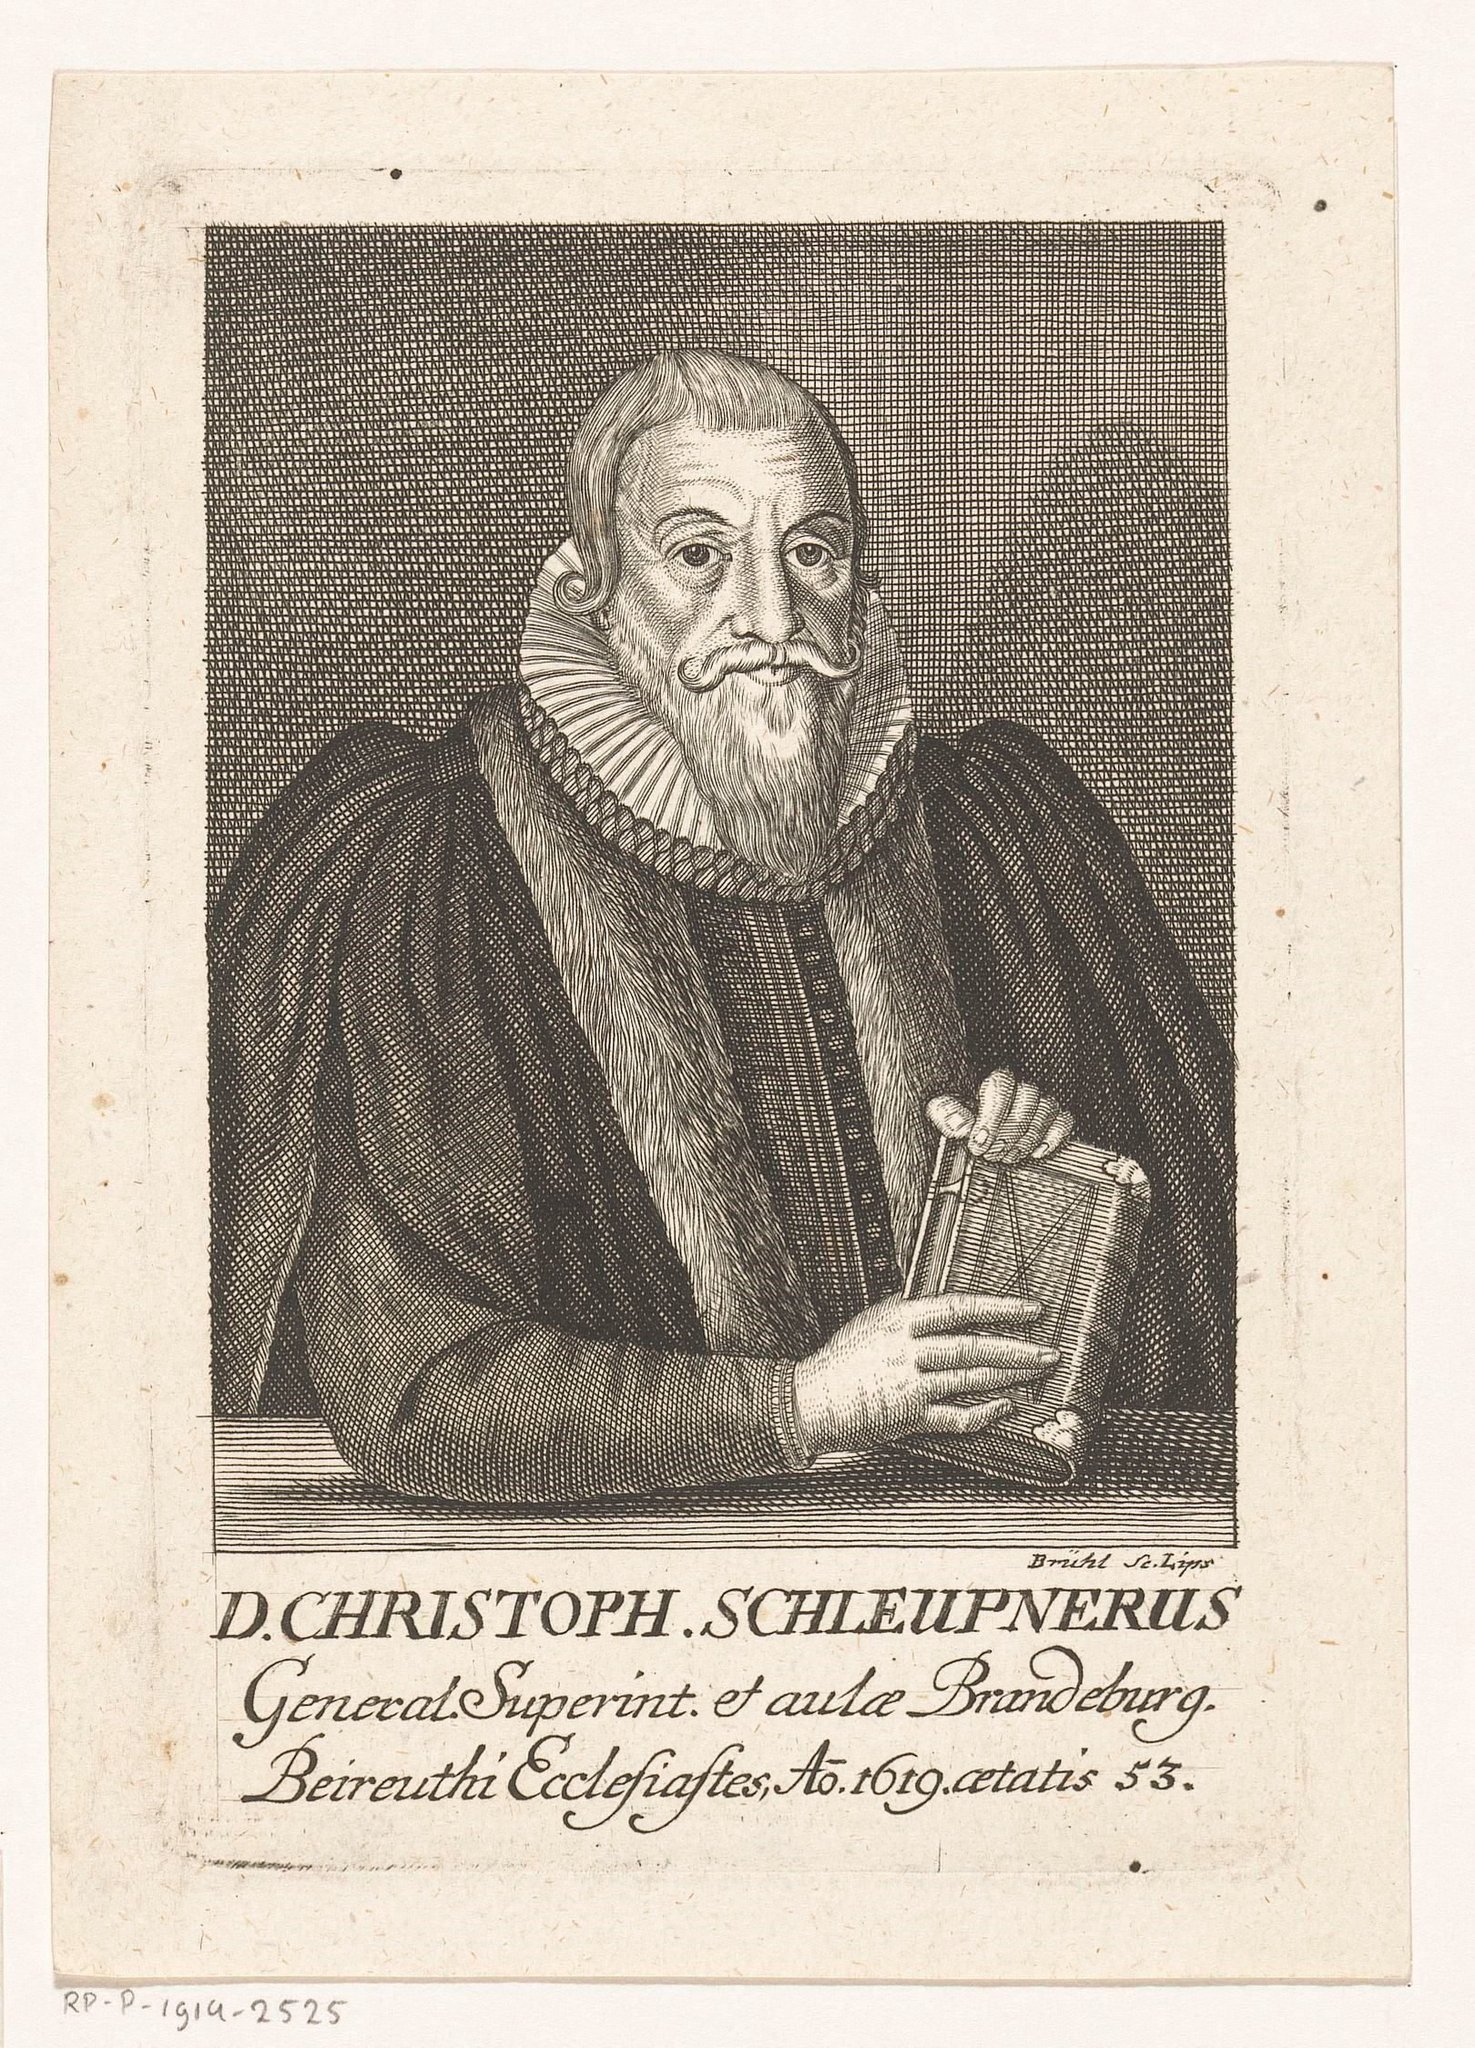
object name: print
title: Portret van Christoph Schleupner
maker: johann benjamin brühl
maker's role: print maker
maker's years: 1691-1763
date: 1740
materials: paper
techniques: engraving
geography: leipzig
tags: historical persons, book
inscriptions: collector's mark: Lugt 2228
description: Prent ook gebruikt in: Fortgesetzte Sammlung Von Alten und Neuen Theologischen Sachen (...) Sechster Beytrag Auf das Jahr 1740. Leipzig: erven Johann Friedrich Braun.